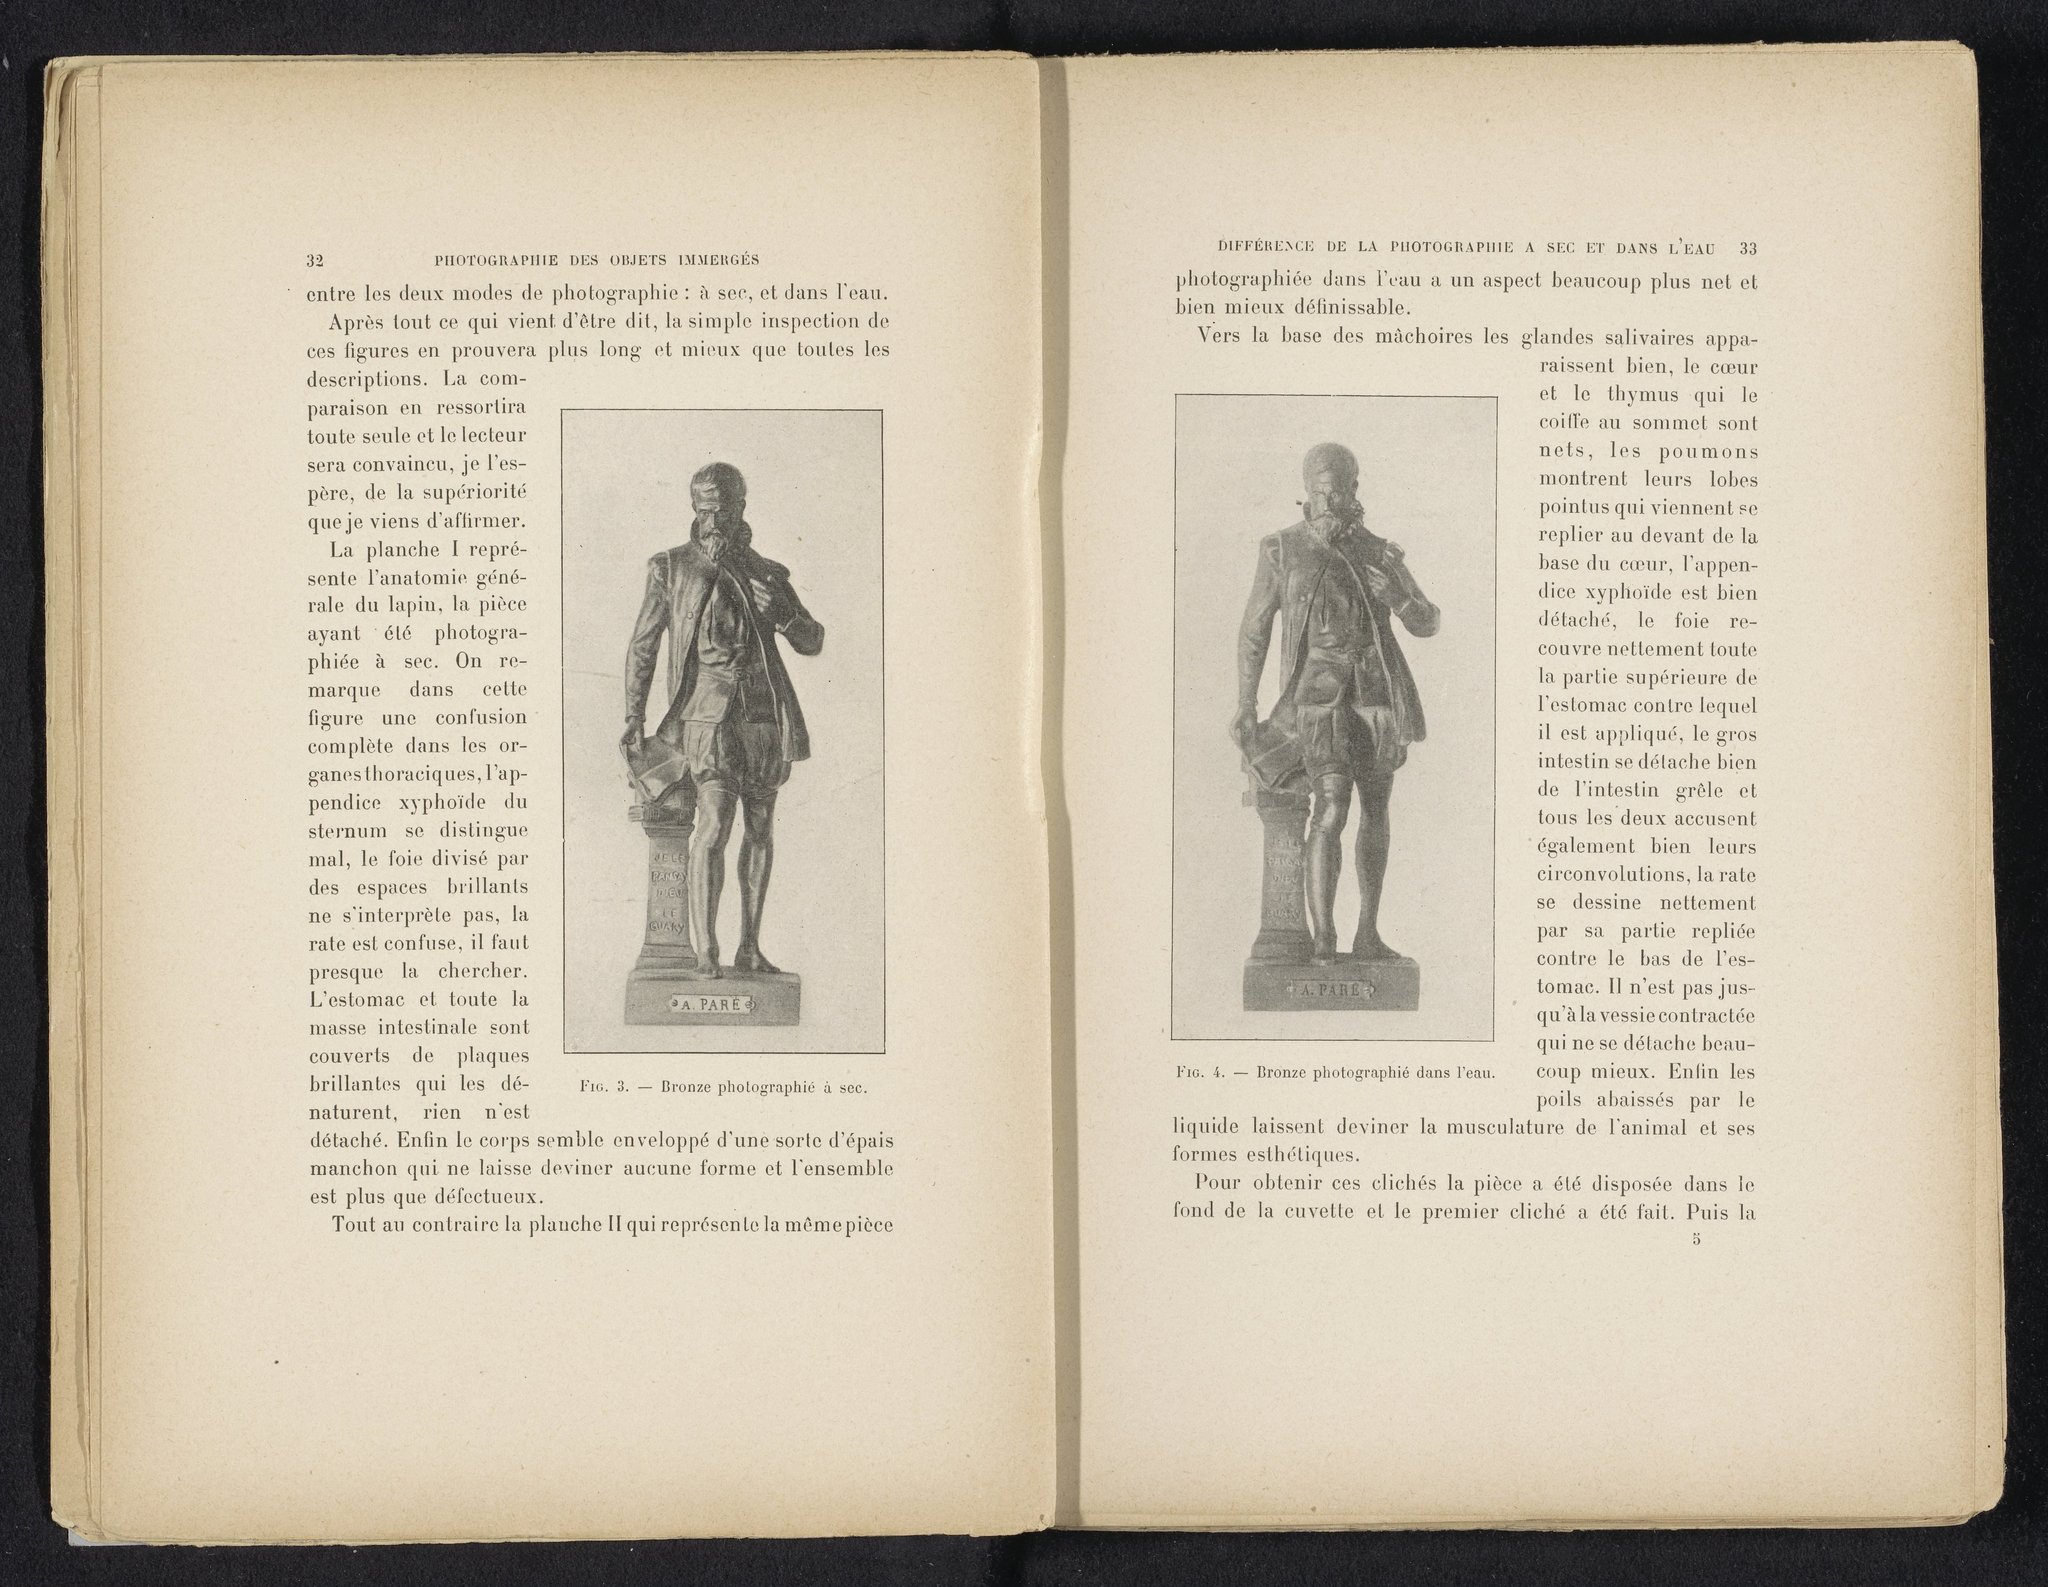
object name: photomechanical print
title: Bronze photographié dans l'eau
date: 1891-1901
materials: paper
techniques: autotype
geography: paris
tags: sculpture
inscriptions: number: ‘Fig. 4.’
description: Prent in album 'La photographie des objets immergés', 1901.